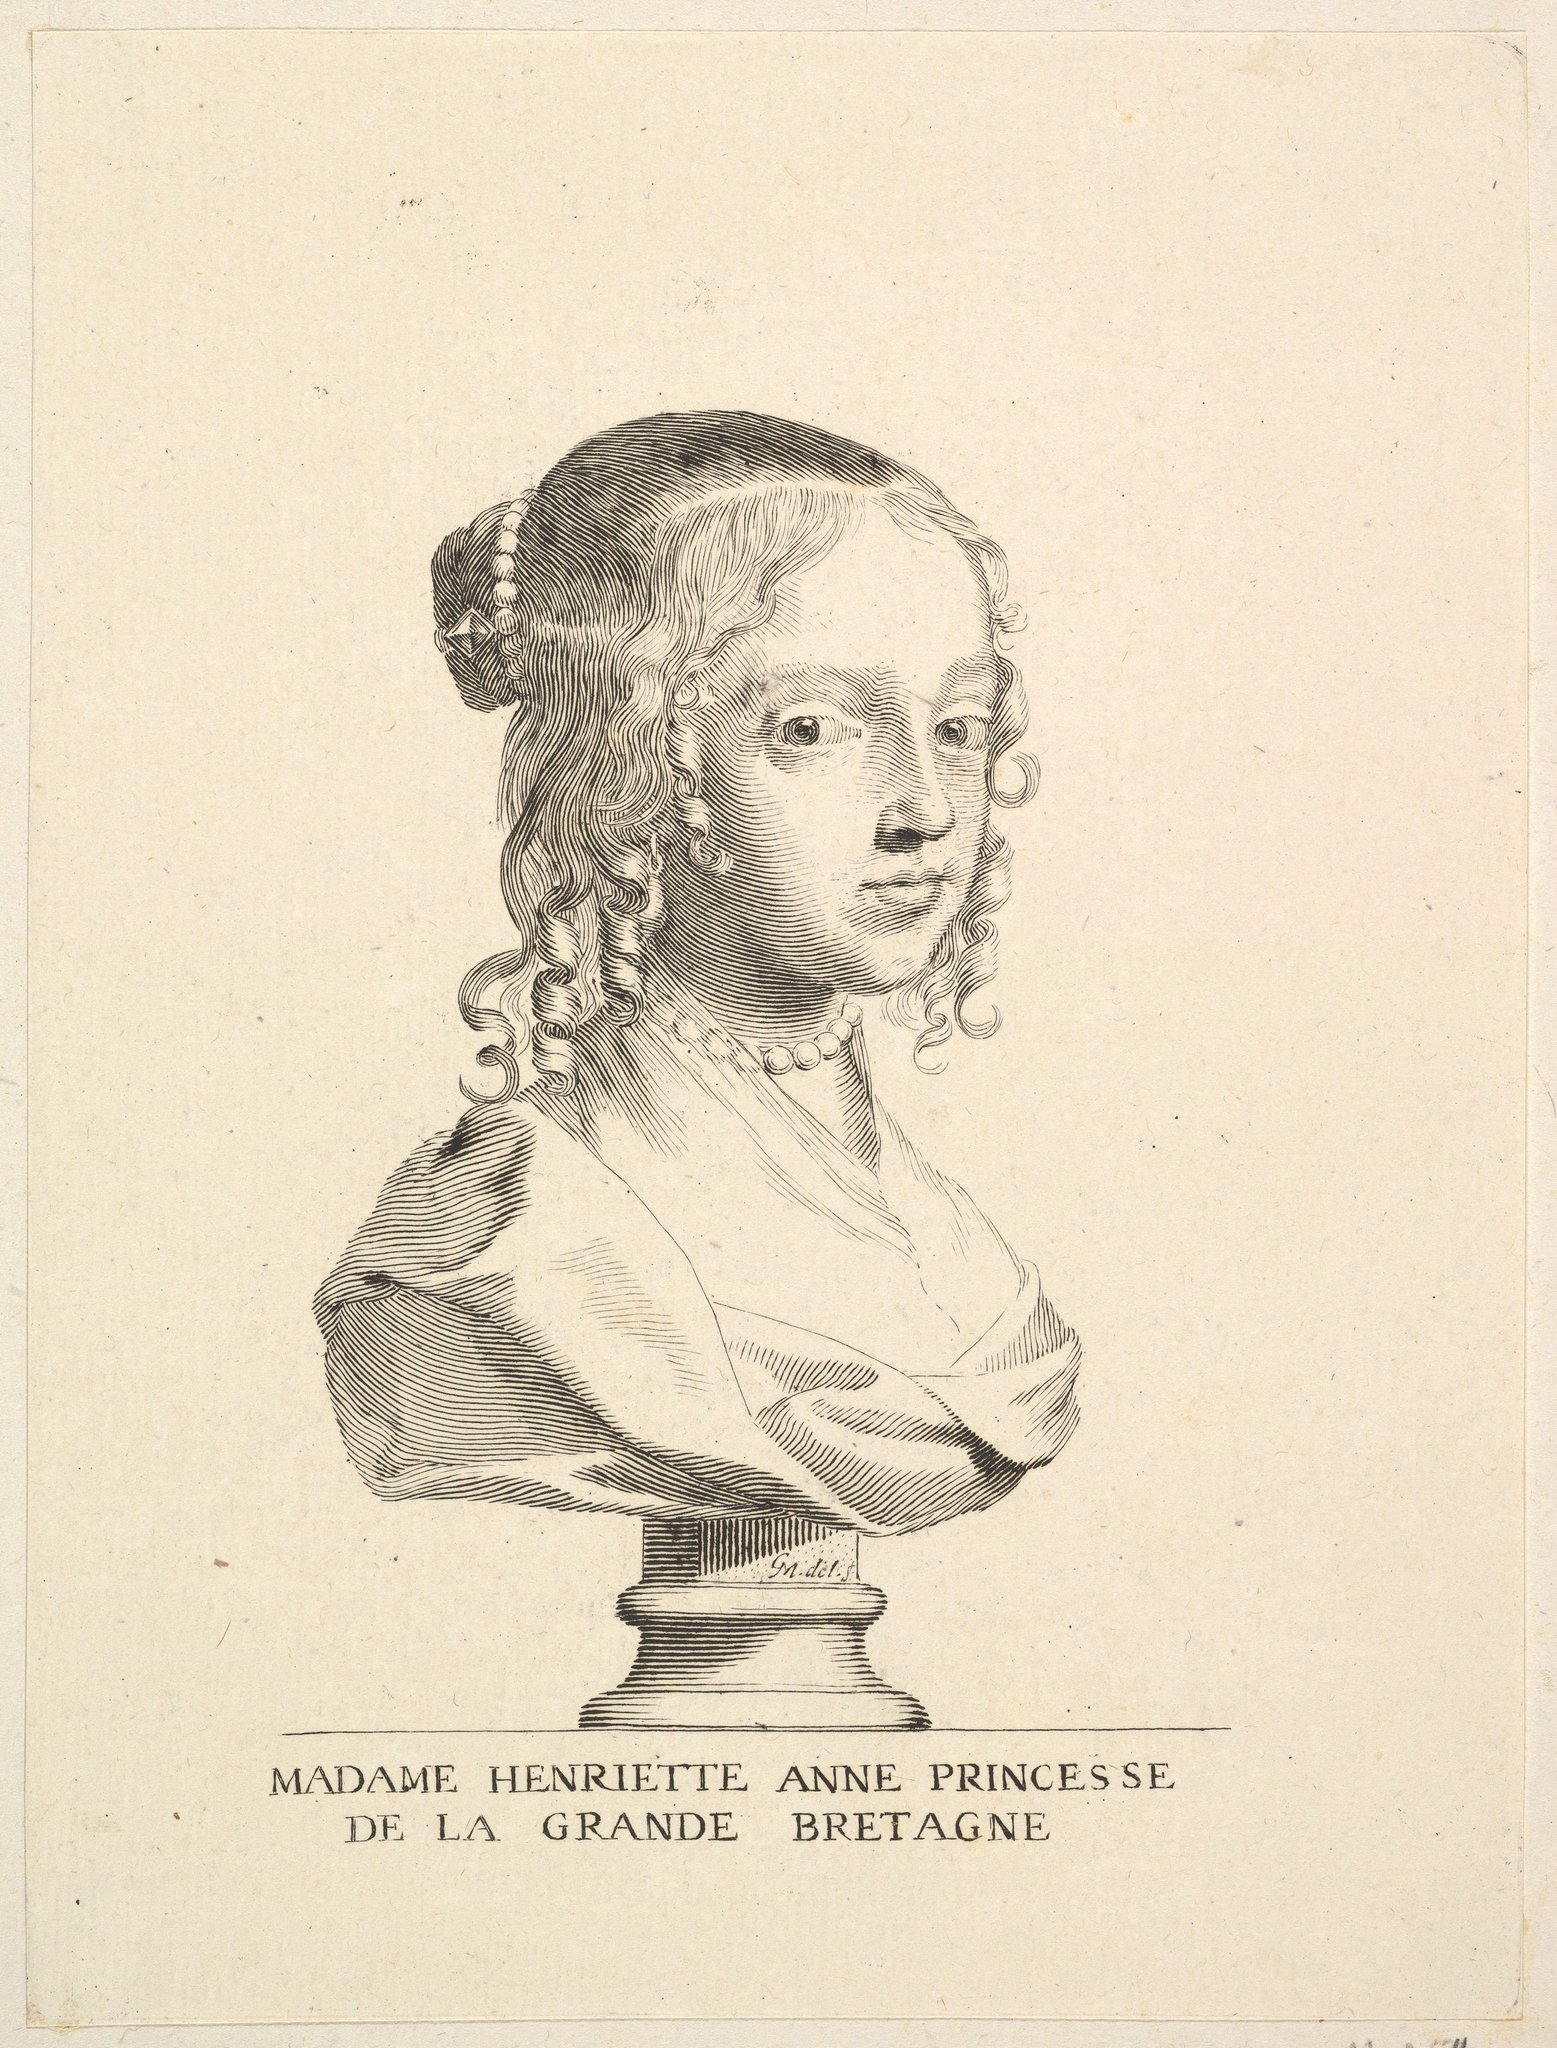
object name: print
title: Henriette-Anne d'Angleterre, duchesse d'Orléans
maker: claude mellan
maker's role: artist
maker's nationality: french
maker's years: 1598-1688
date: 1644-1670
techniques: engraving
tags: portraits,women